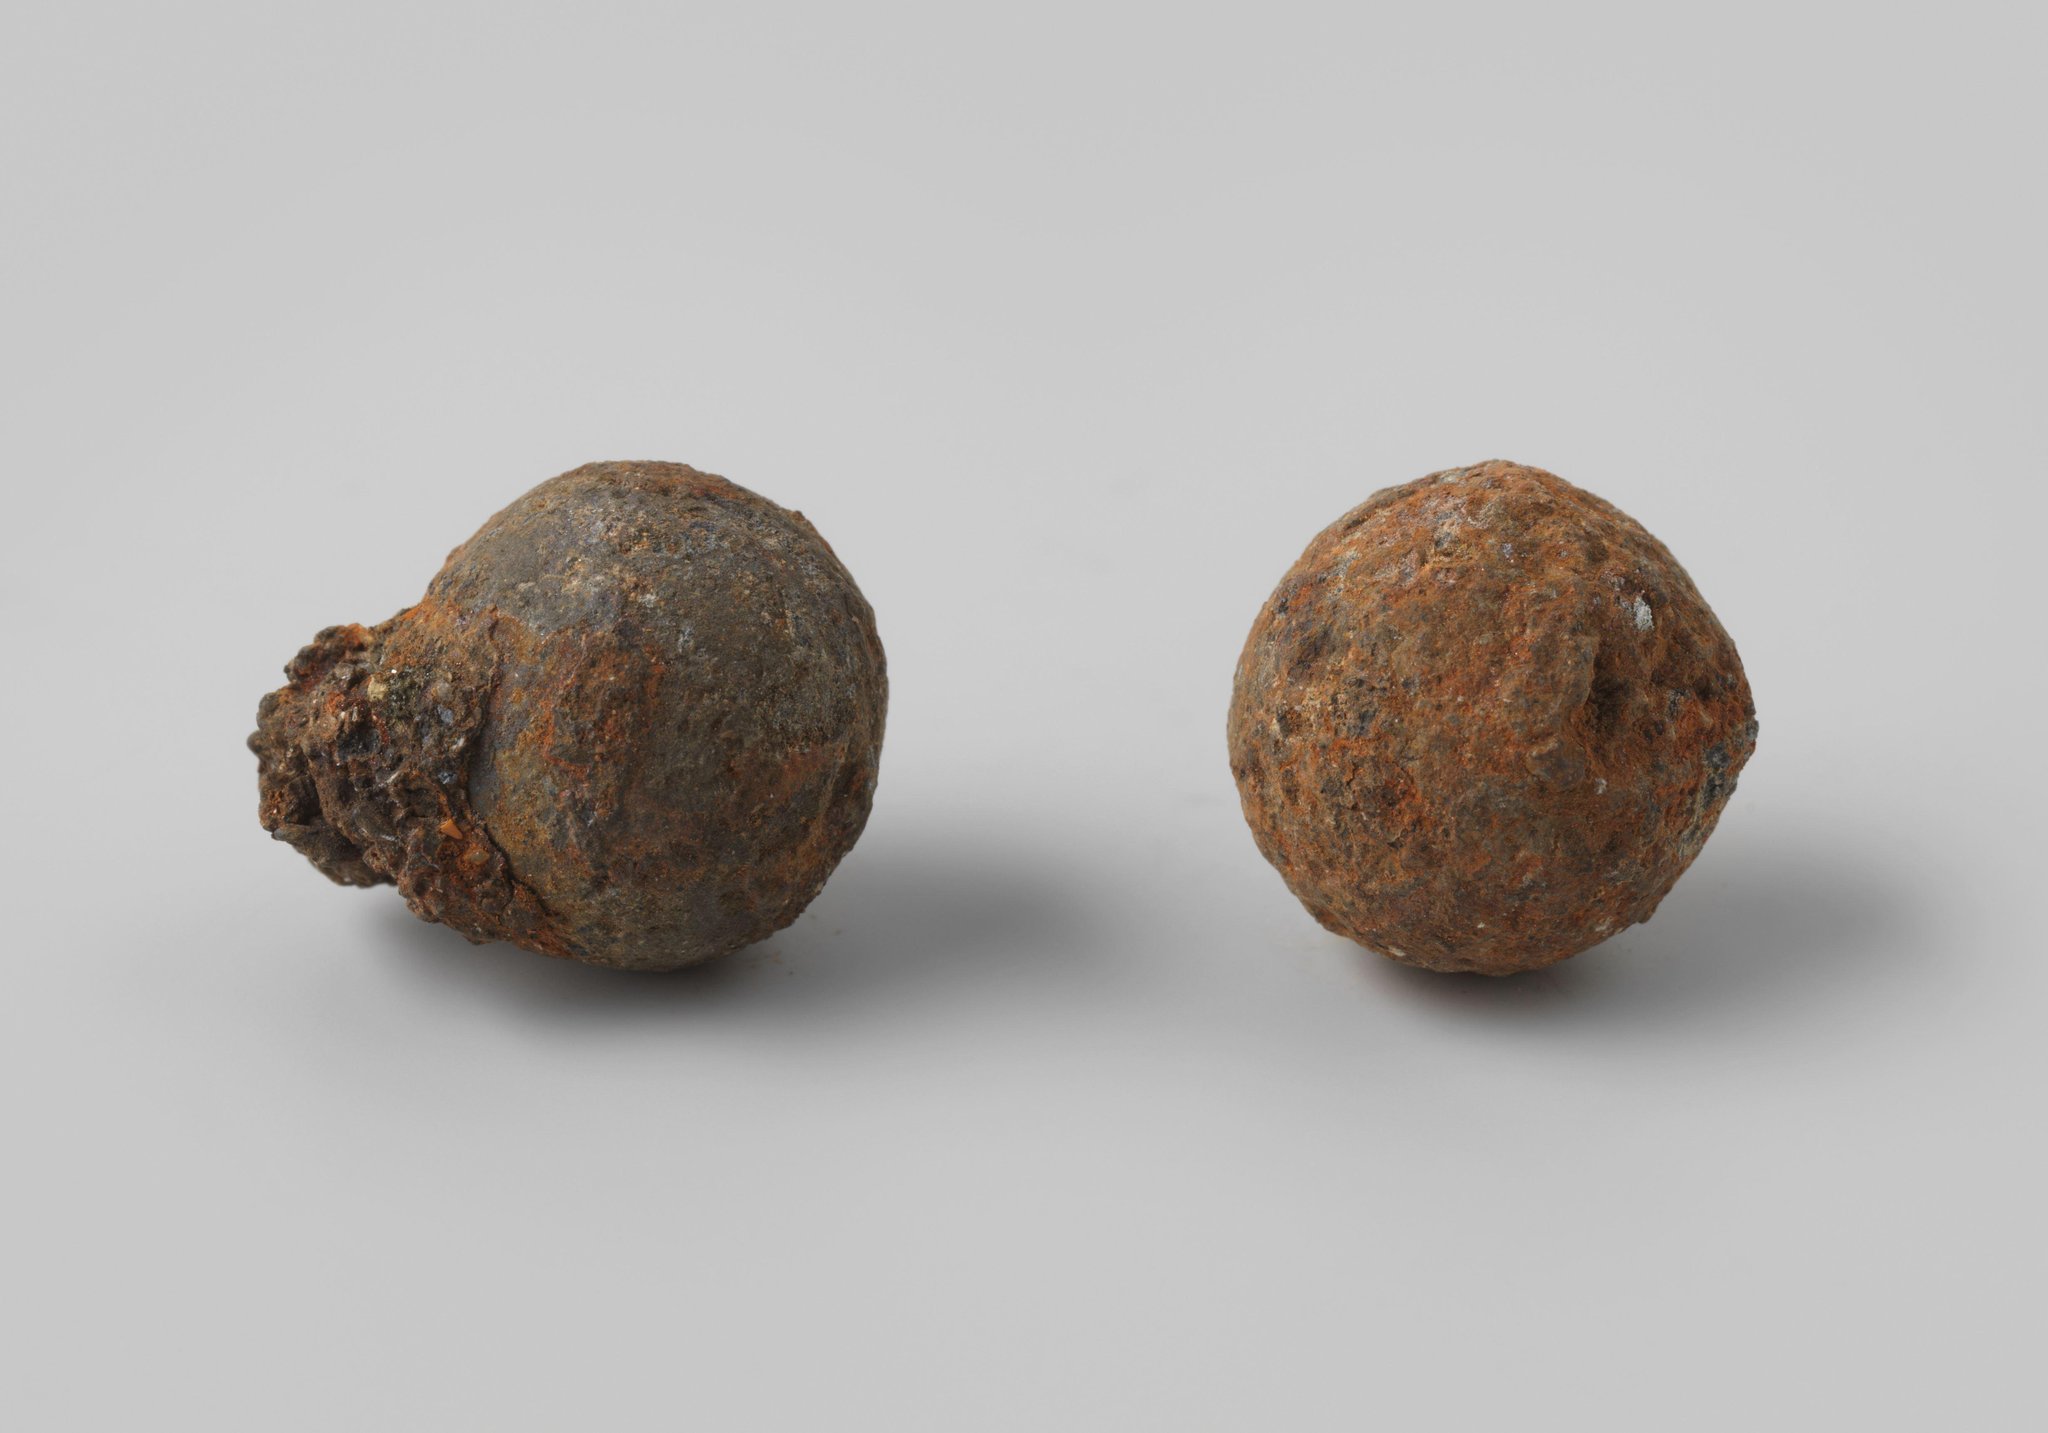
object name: musketkogel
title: Musketkogels uit het wrak van de Oost-Indiëvaarder Hollandia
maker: Anonymous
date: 1700-1743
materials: lead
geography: netherlands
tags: verenigde oostindische compagnie, hollandia (schip), annet